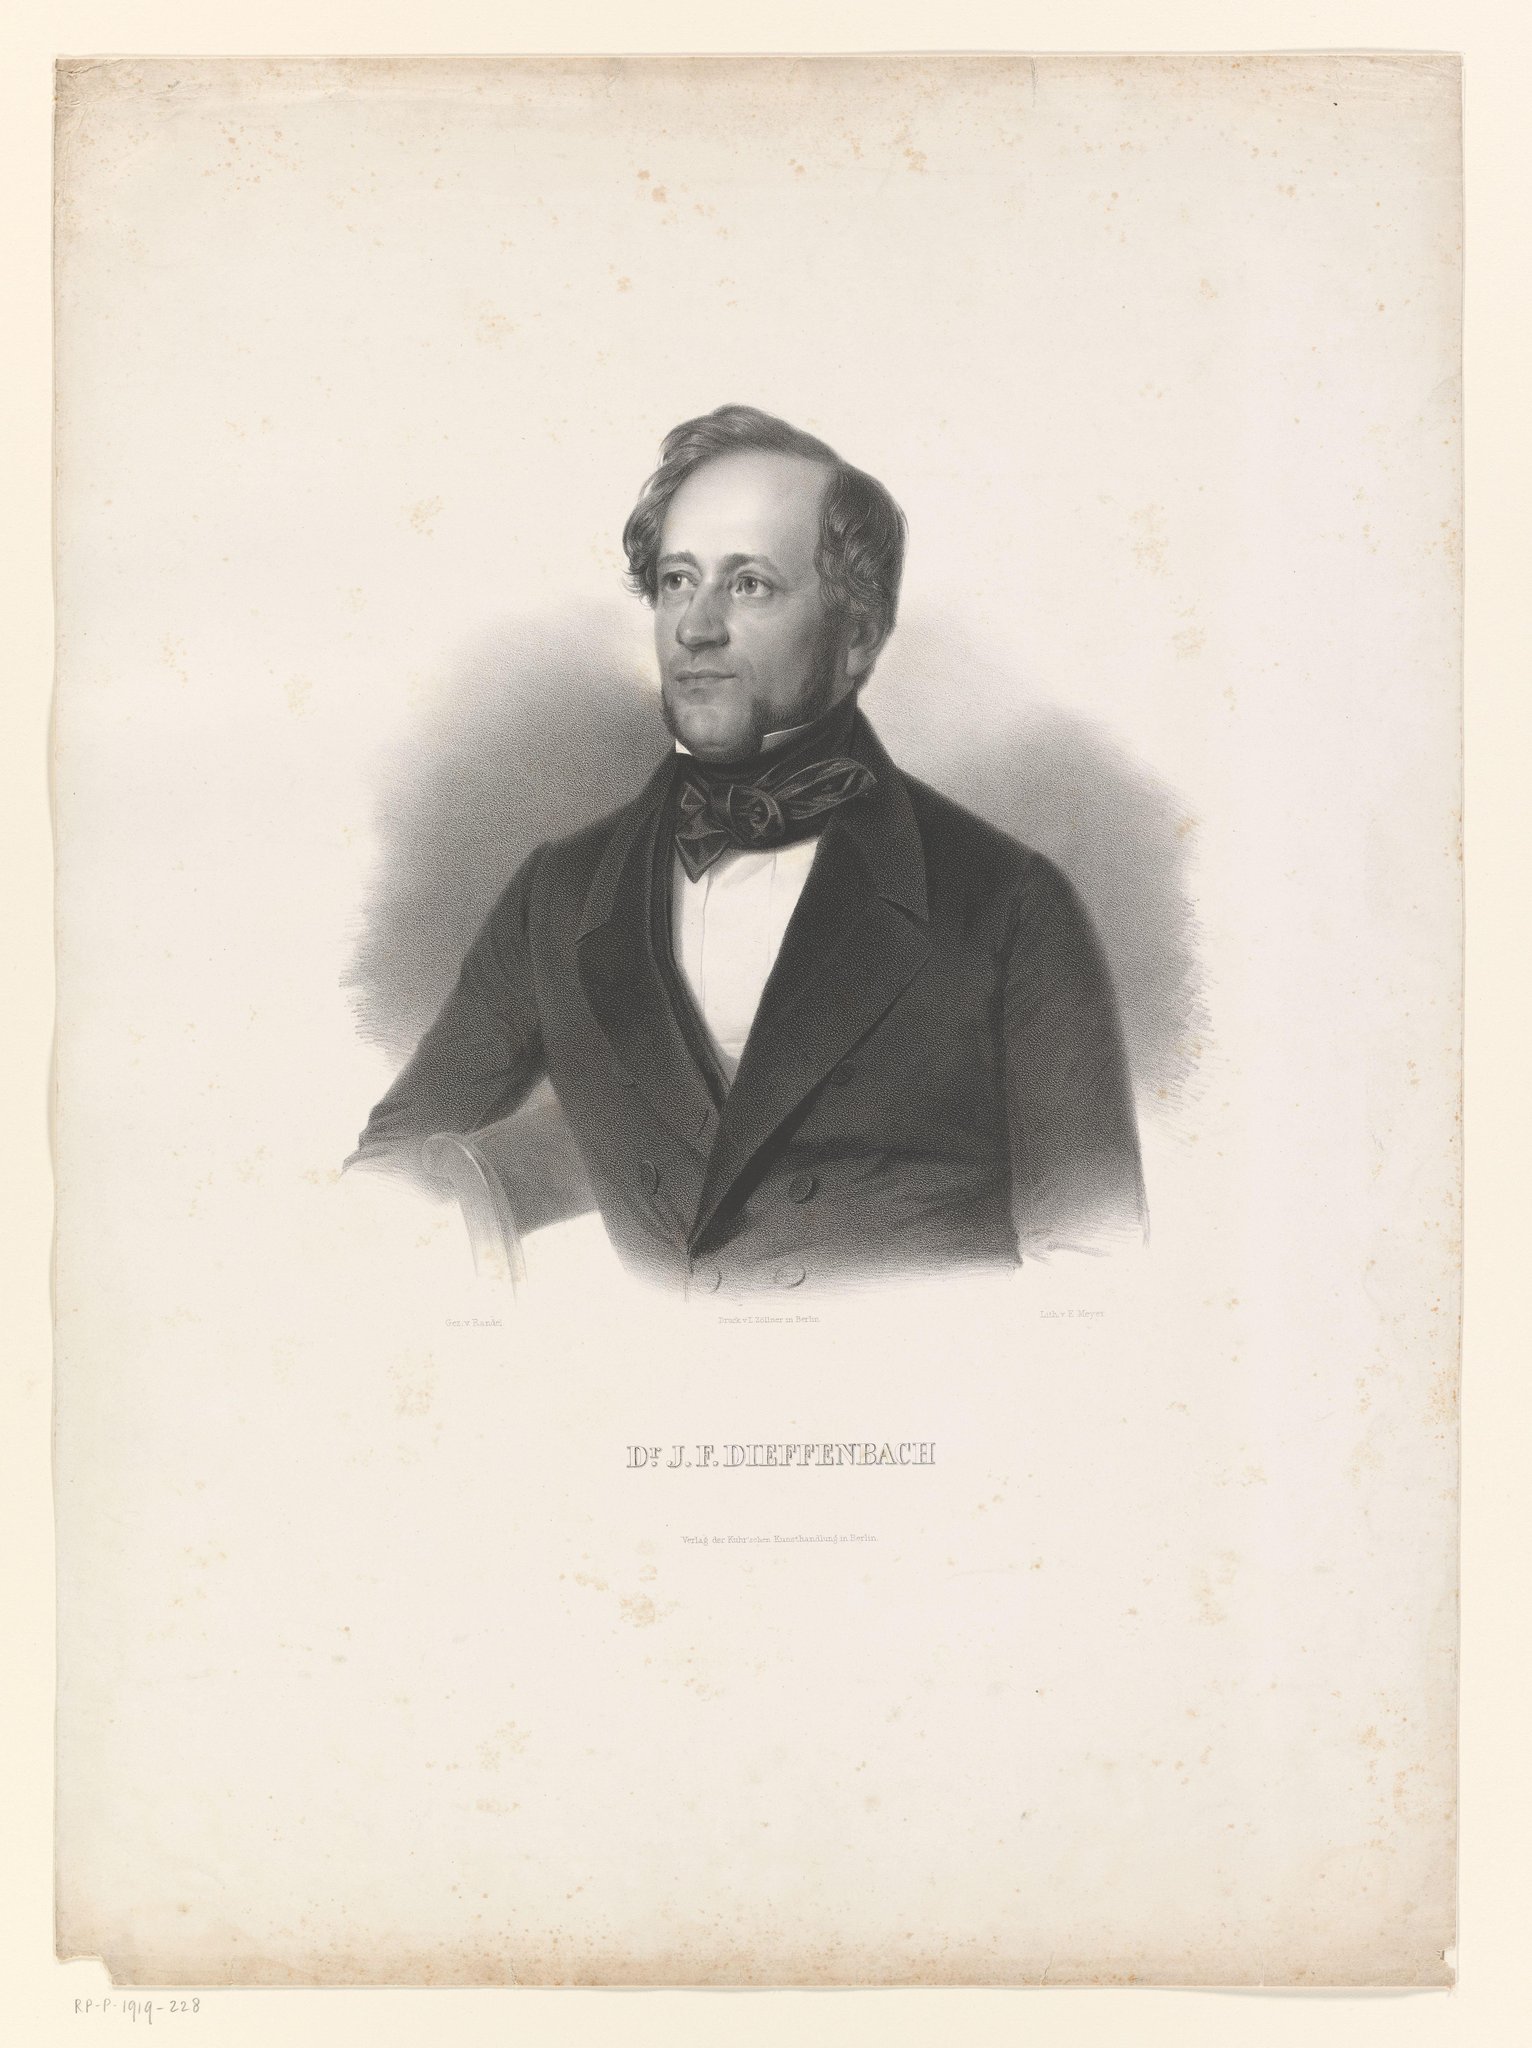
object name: print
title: Portret van Johann Friedrich Dieffenbach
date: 1820-1840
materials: paper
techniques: lithograph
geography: berlin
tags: berlin, adult man, historical persons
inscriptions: collector's mark: Lugt 2228